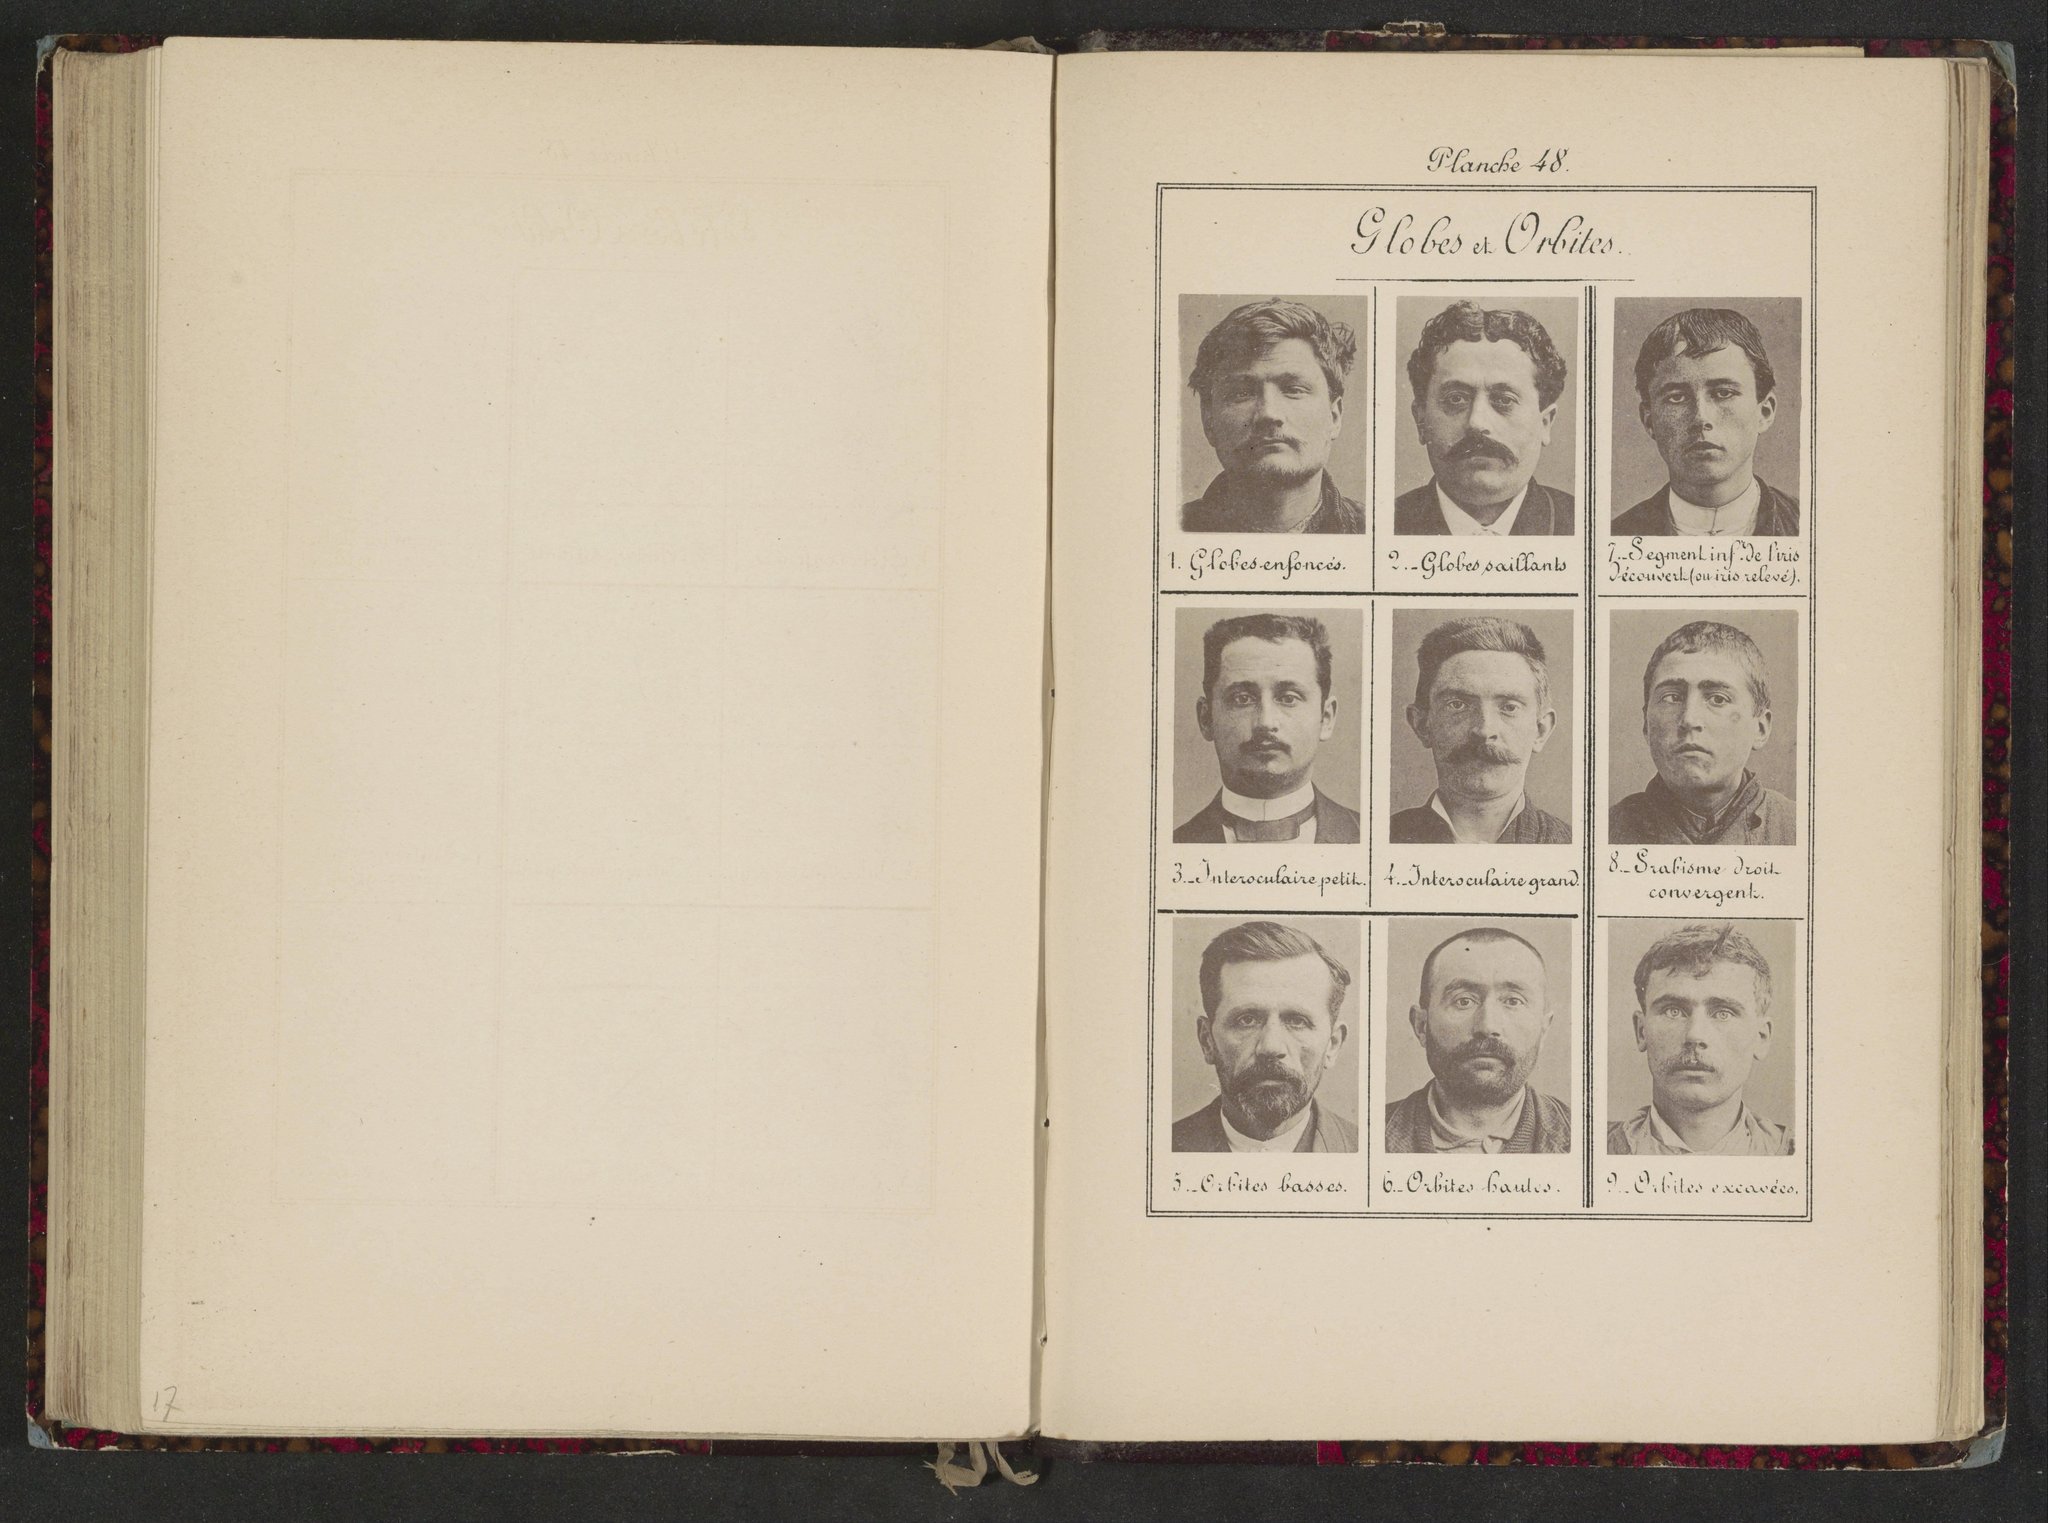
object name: photomechanical print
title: Negen mannenhoofden in vooraanzicht, gerangschikt op de vorm van hun ogen en oogkassen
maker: Anonymous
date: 1880-1893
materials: paper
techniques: photograph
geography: france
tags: head (human) (+ front view), eyes, france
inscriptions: inscription: ‘Globes enfoncés. (...) Orbites excavées.’, number: ‘Planche 48.’, number: ‘1. (...) 9.’